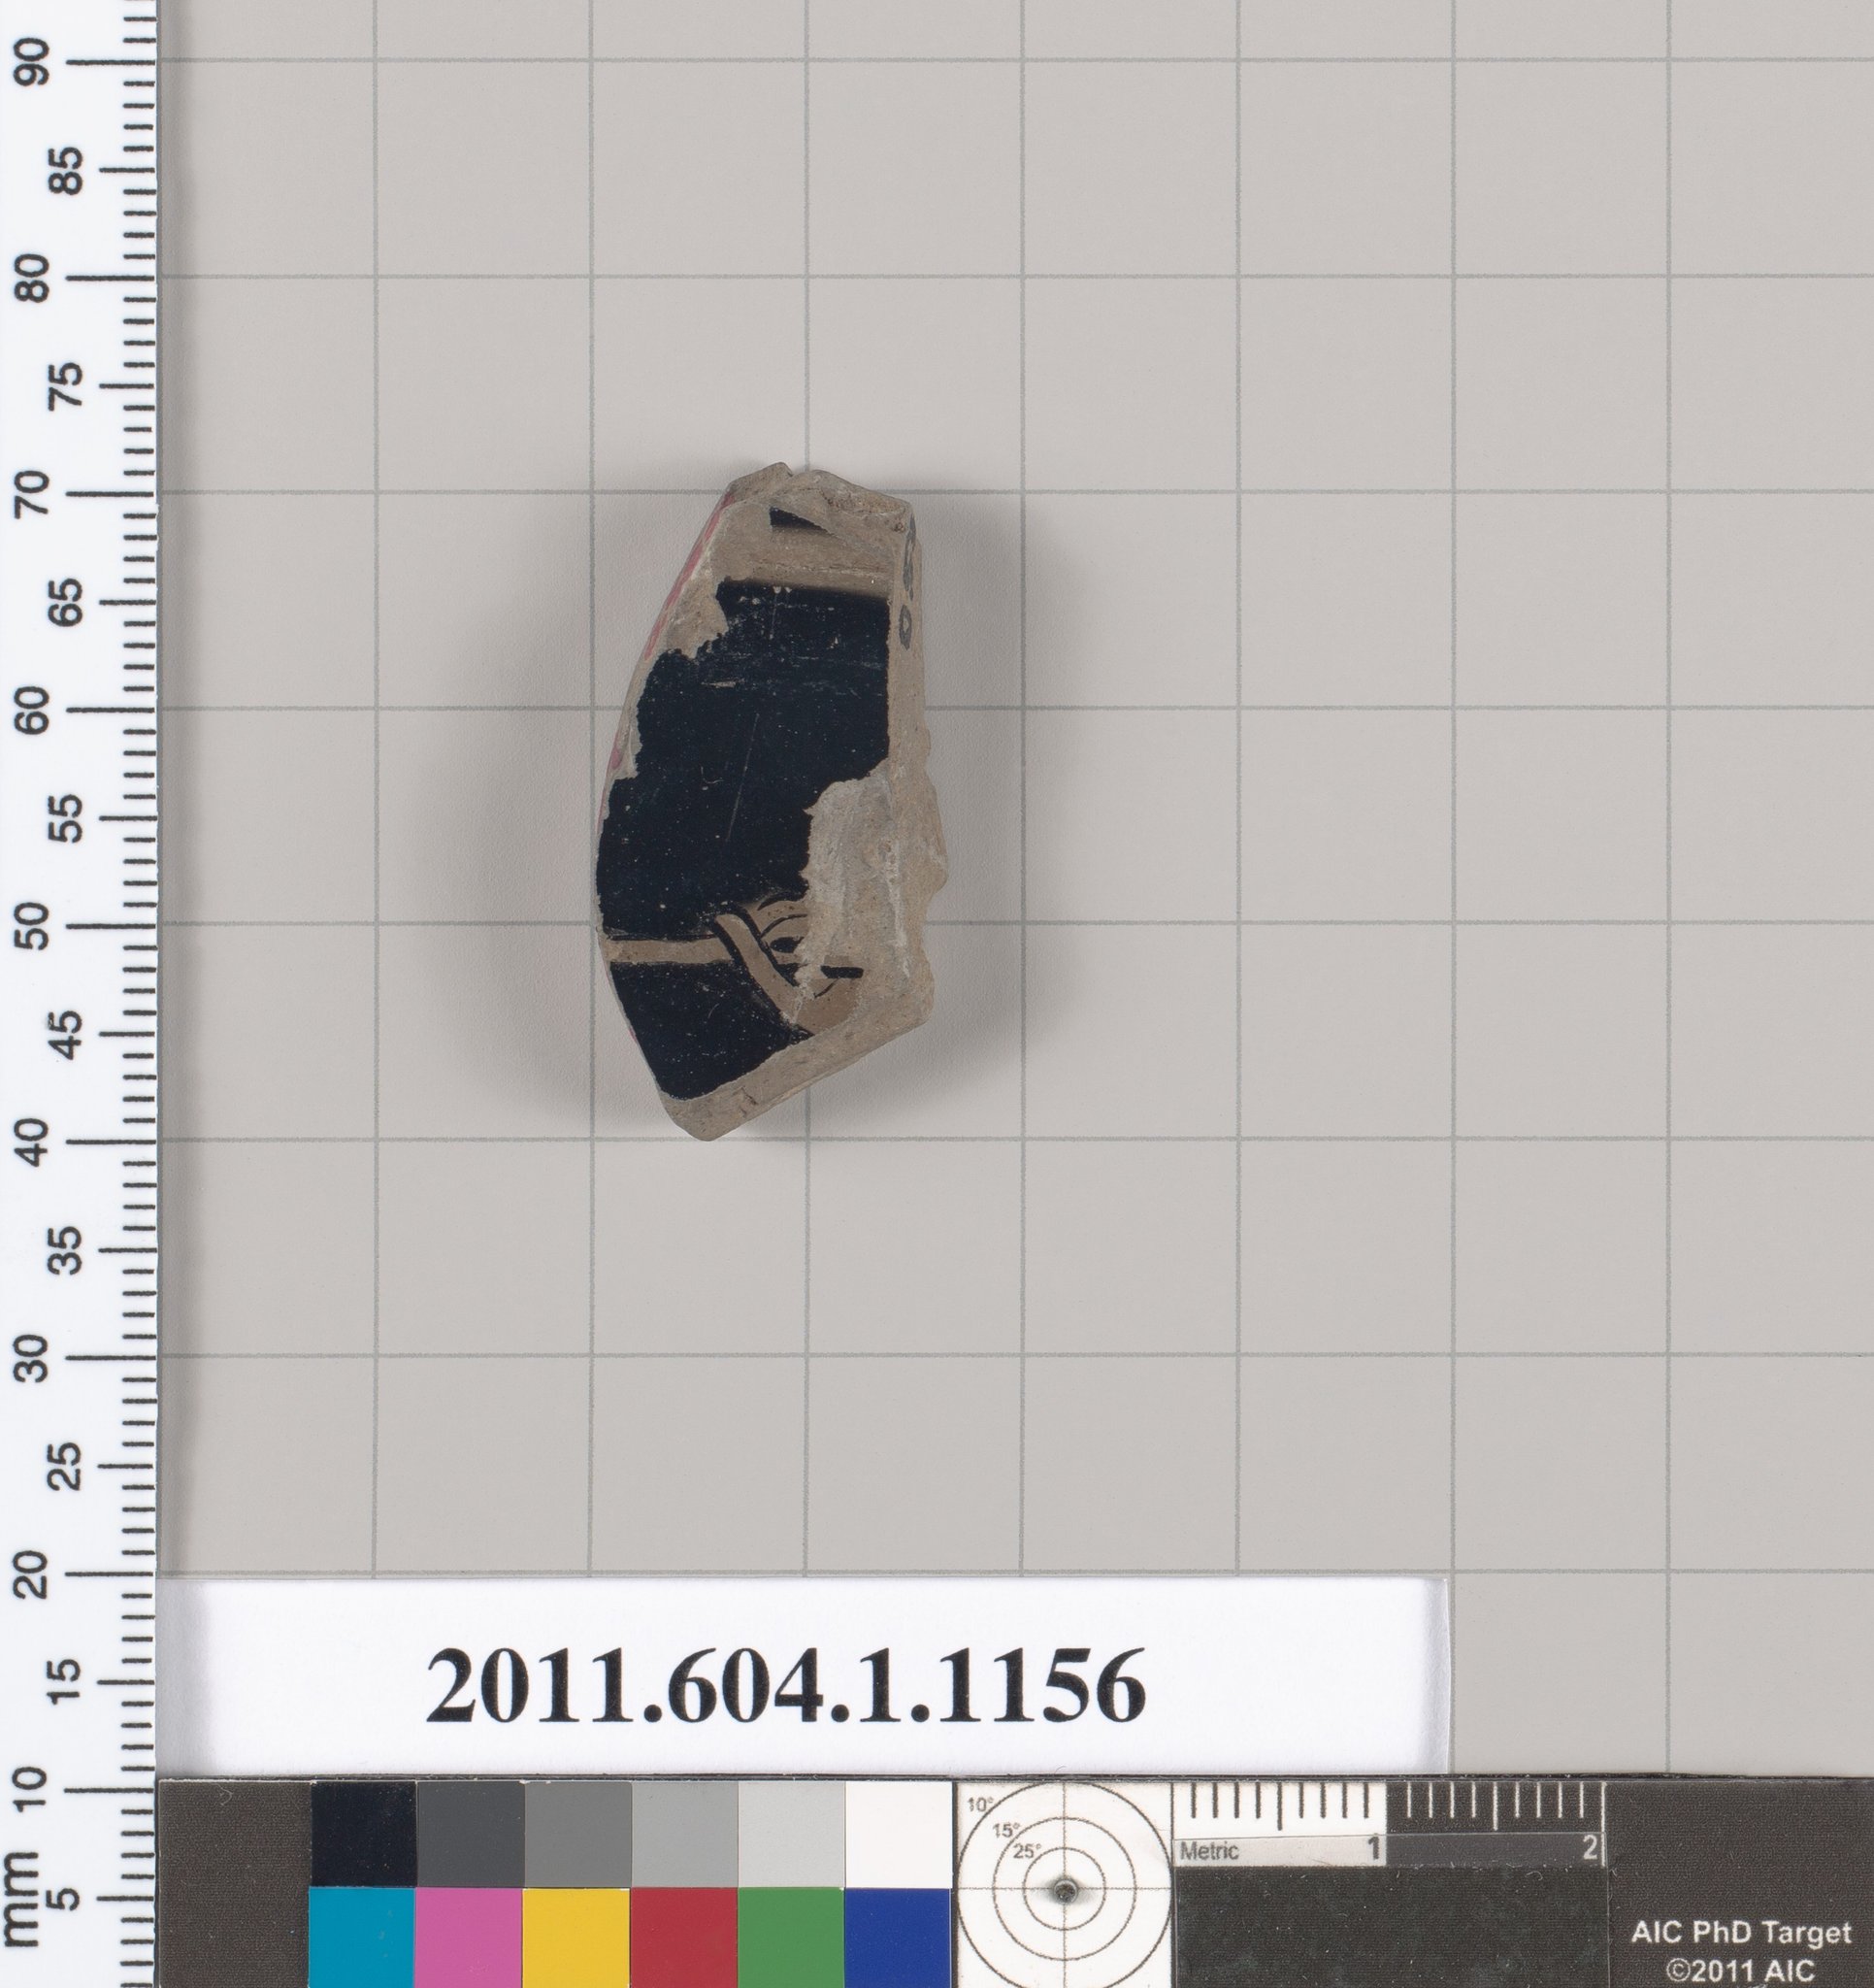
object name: kylix fragment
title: Terracotta fragment of a kylix (drinking cup)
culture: greek, attic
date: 490-480 BCE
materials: terracotta